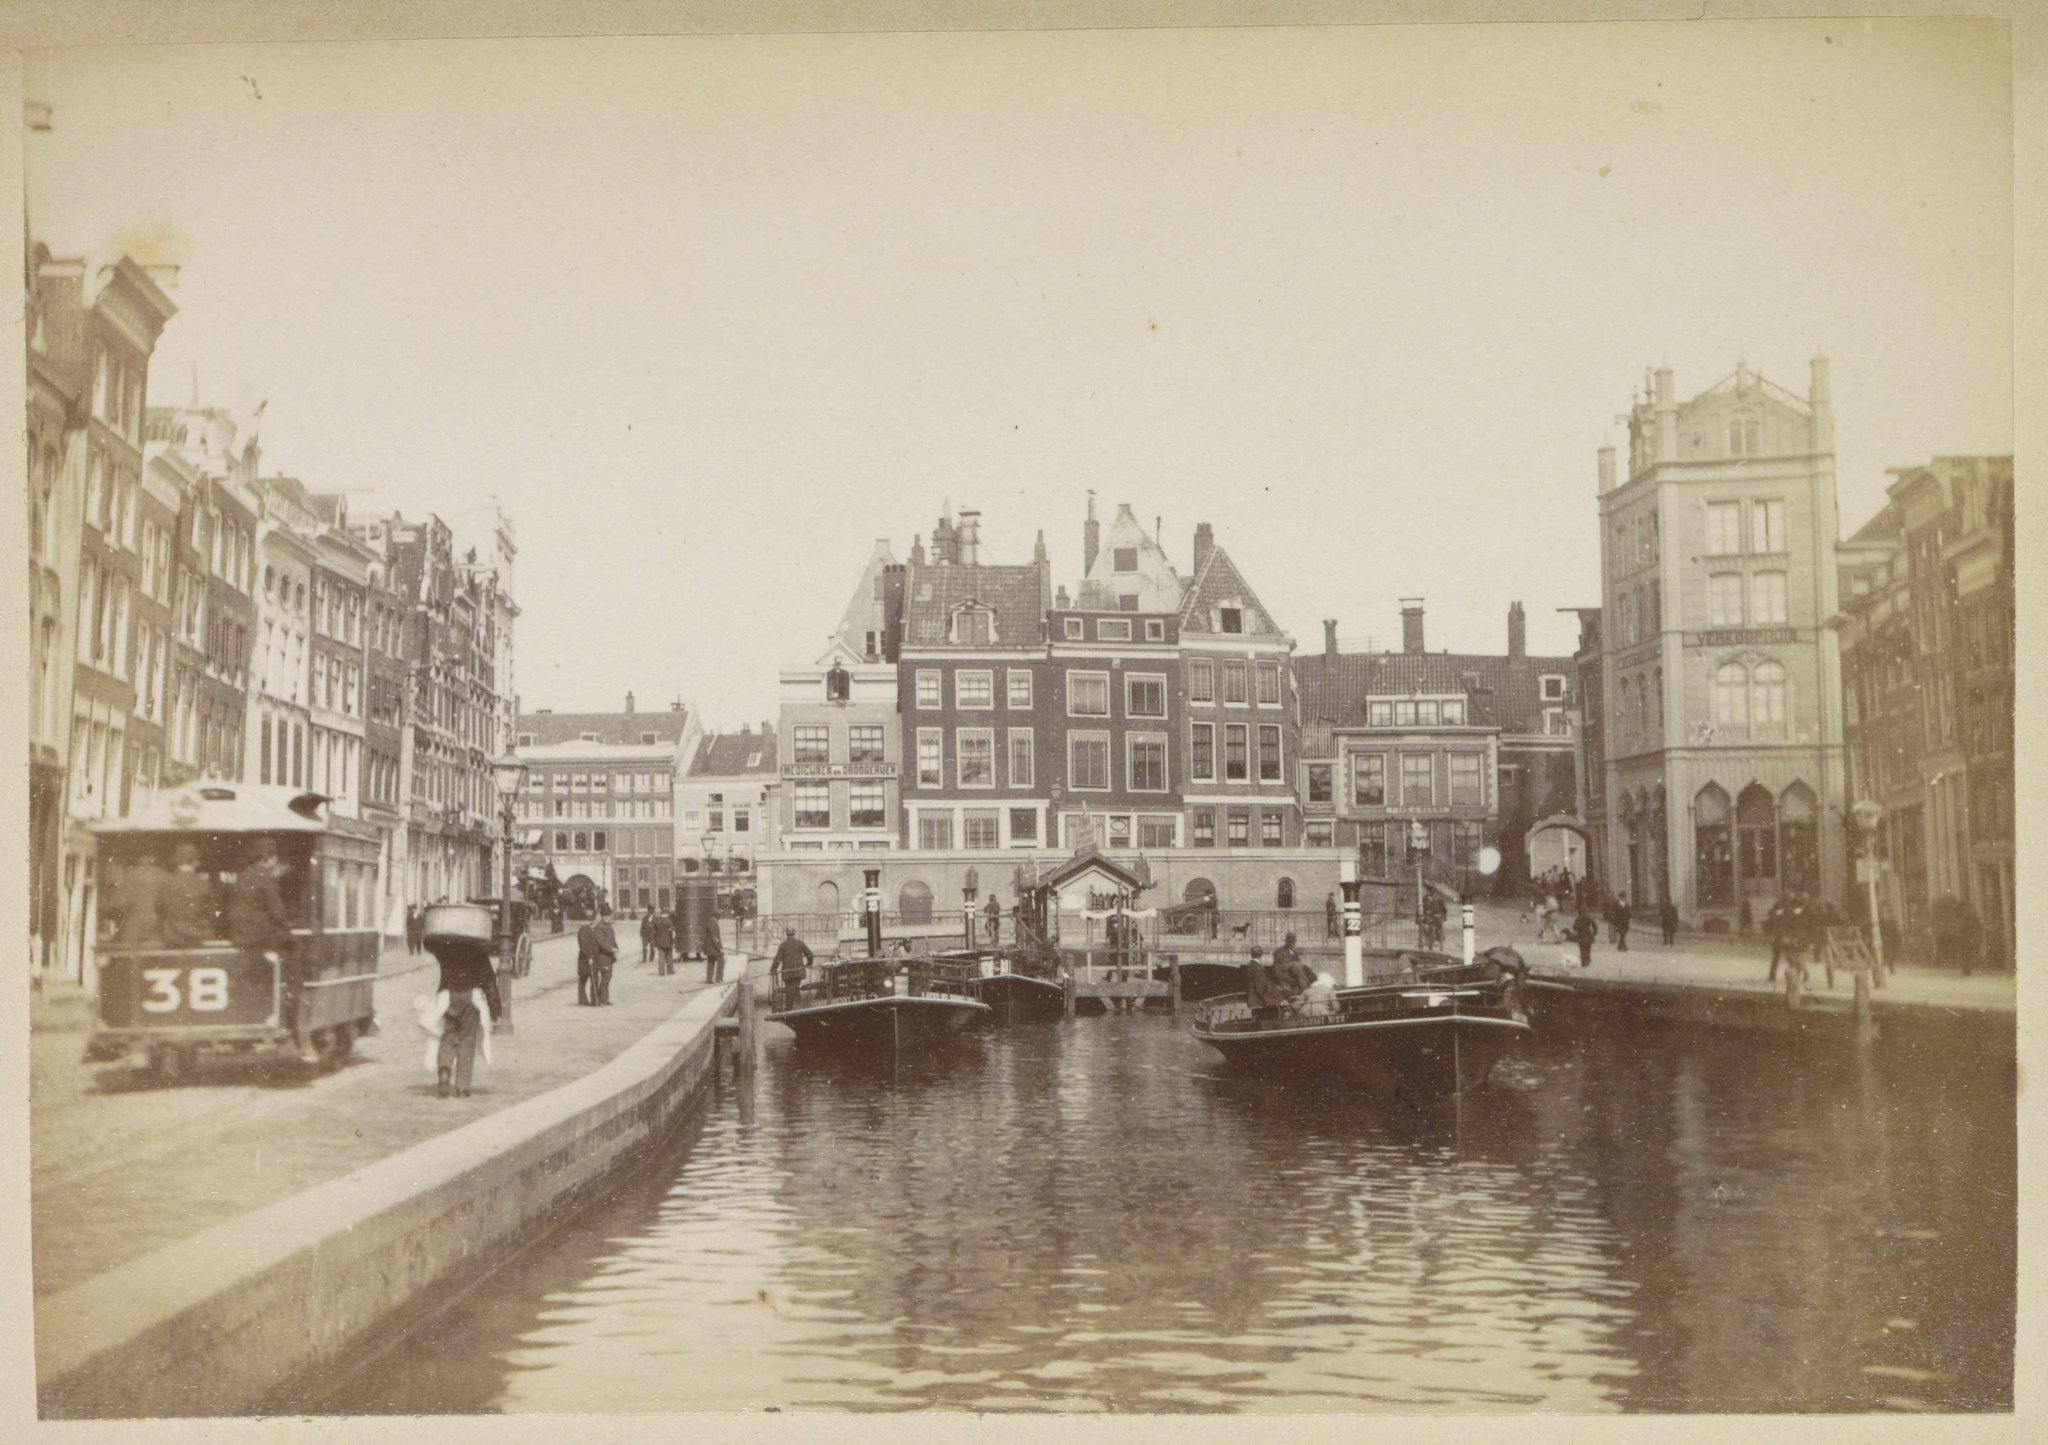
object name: photograph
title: Het Rokin. Amsterdam.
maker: andries jager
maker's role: publisher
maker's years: 1825-1905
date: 1860-1900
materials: cardboard, photographic support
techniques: albumen print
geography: amsterdam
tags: diligence, omnibus, horse-tram, canal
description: Onderdeel van Leporelloalbum met 24 foto's van Amsterdam.